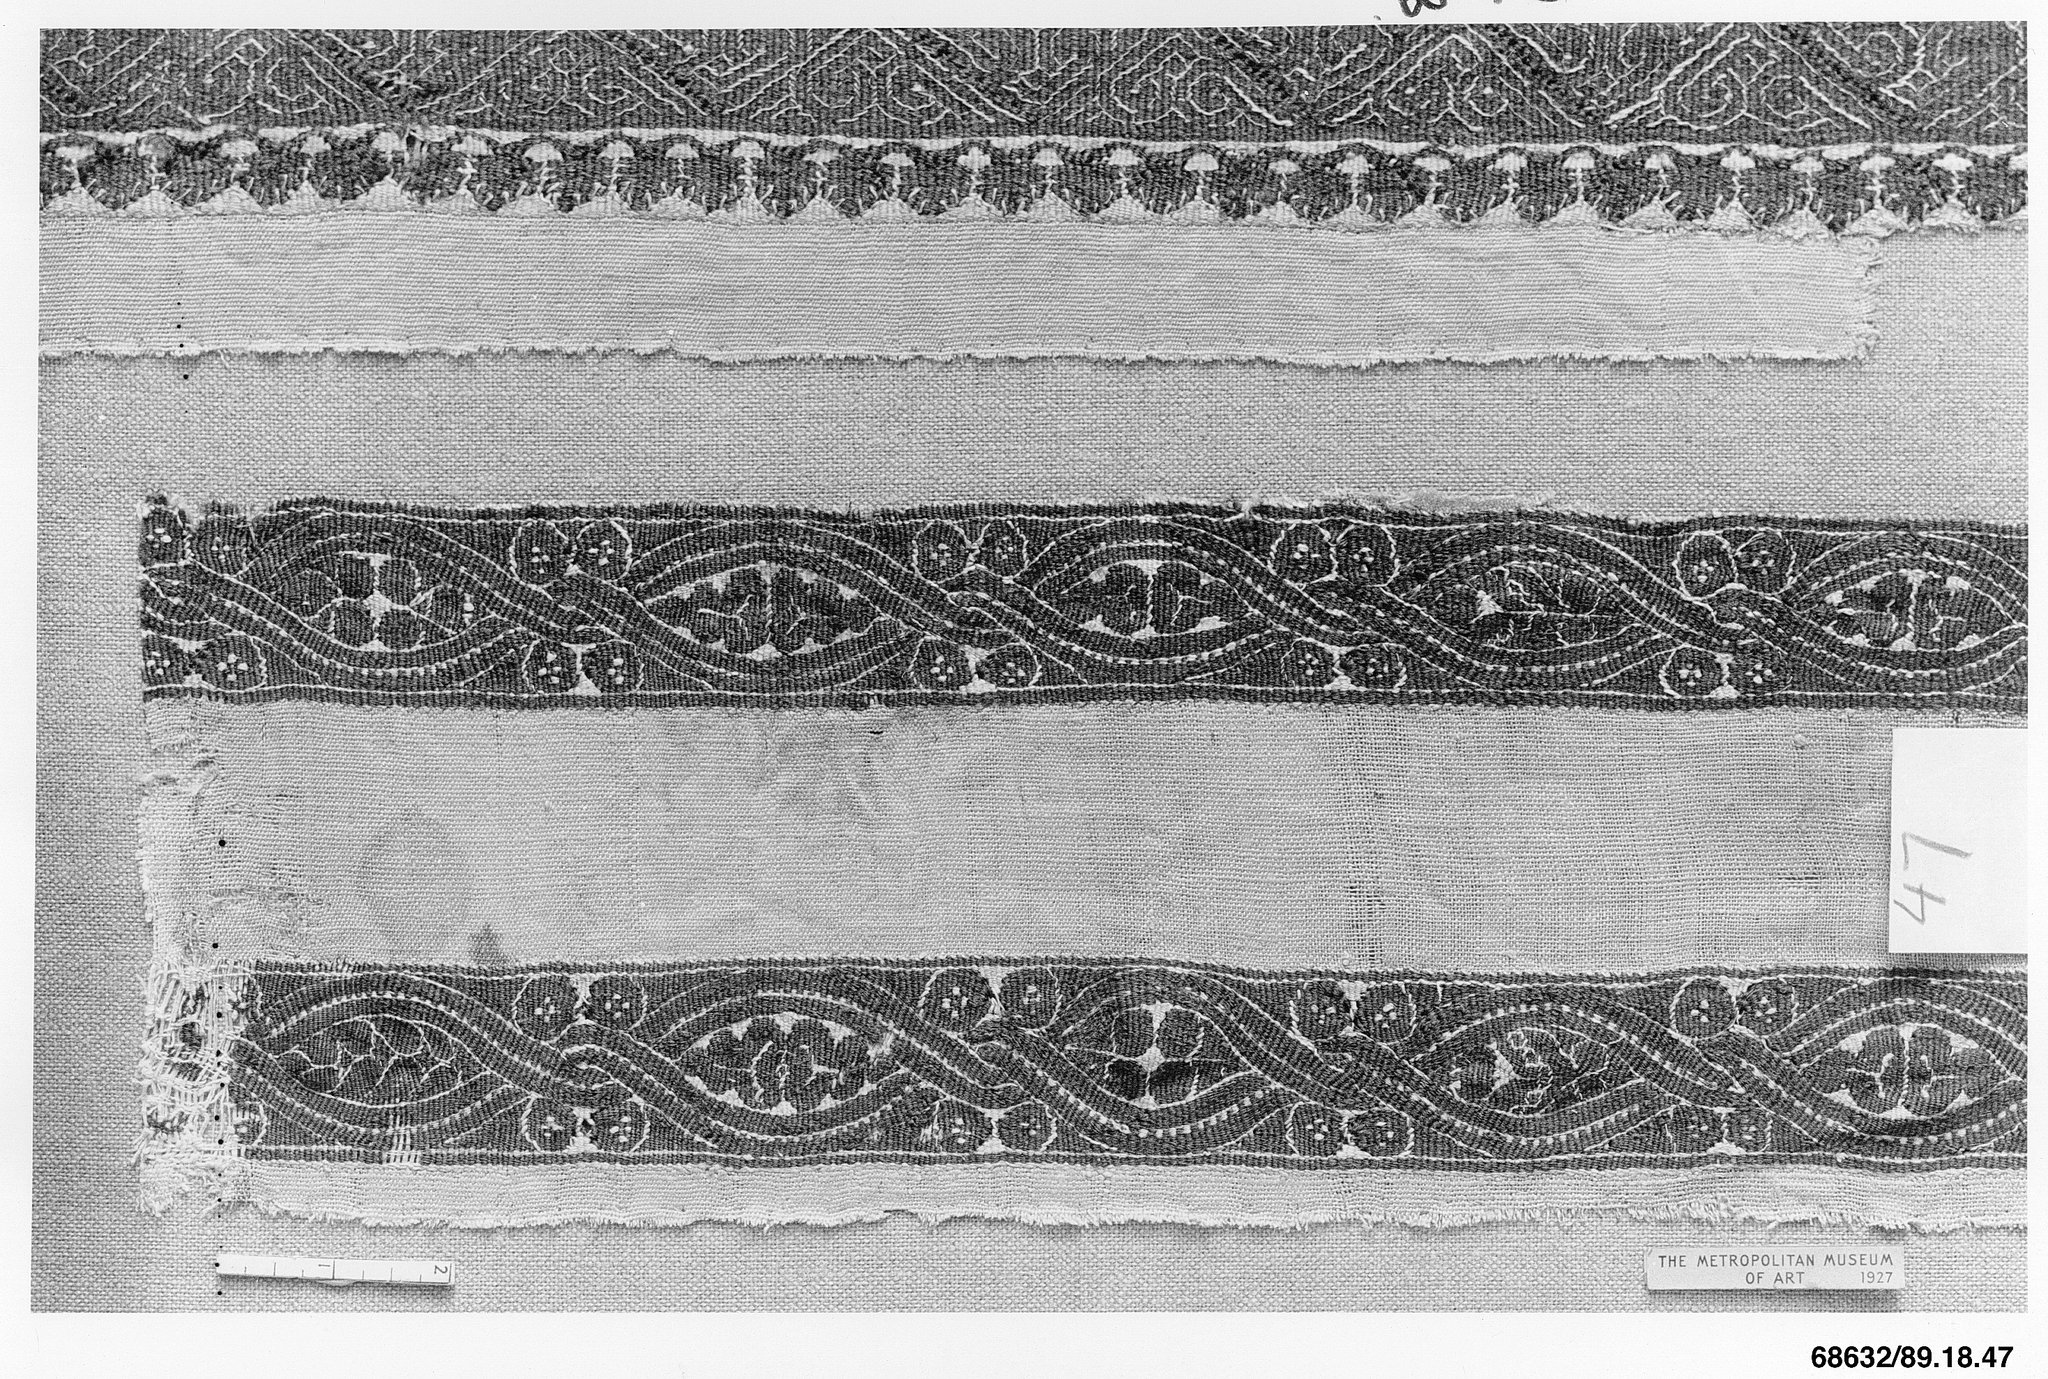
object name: textile fragment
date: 201-400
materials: linen, wool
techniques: weave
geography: egypt